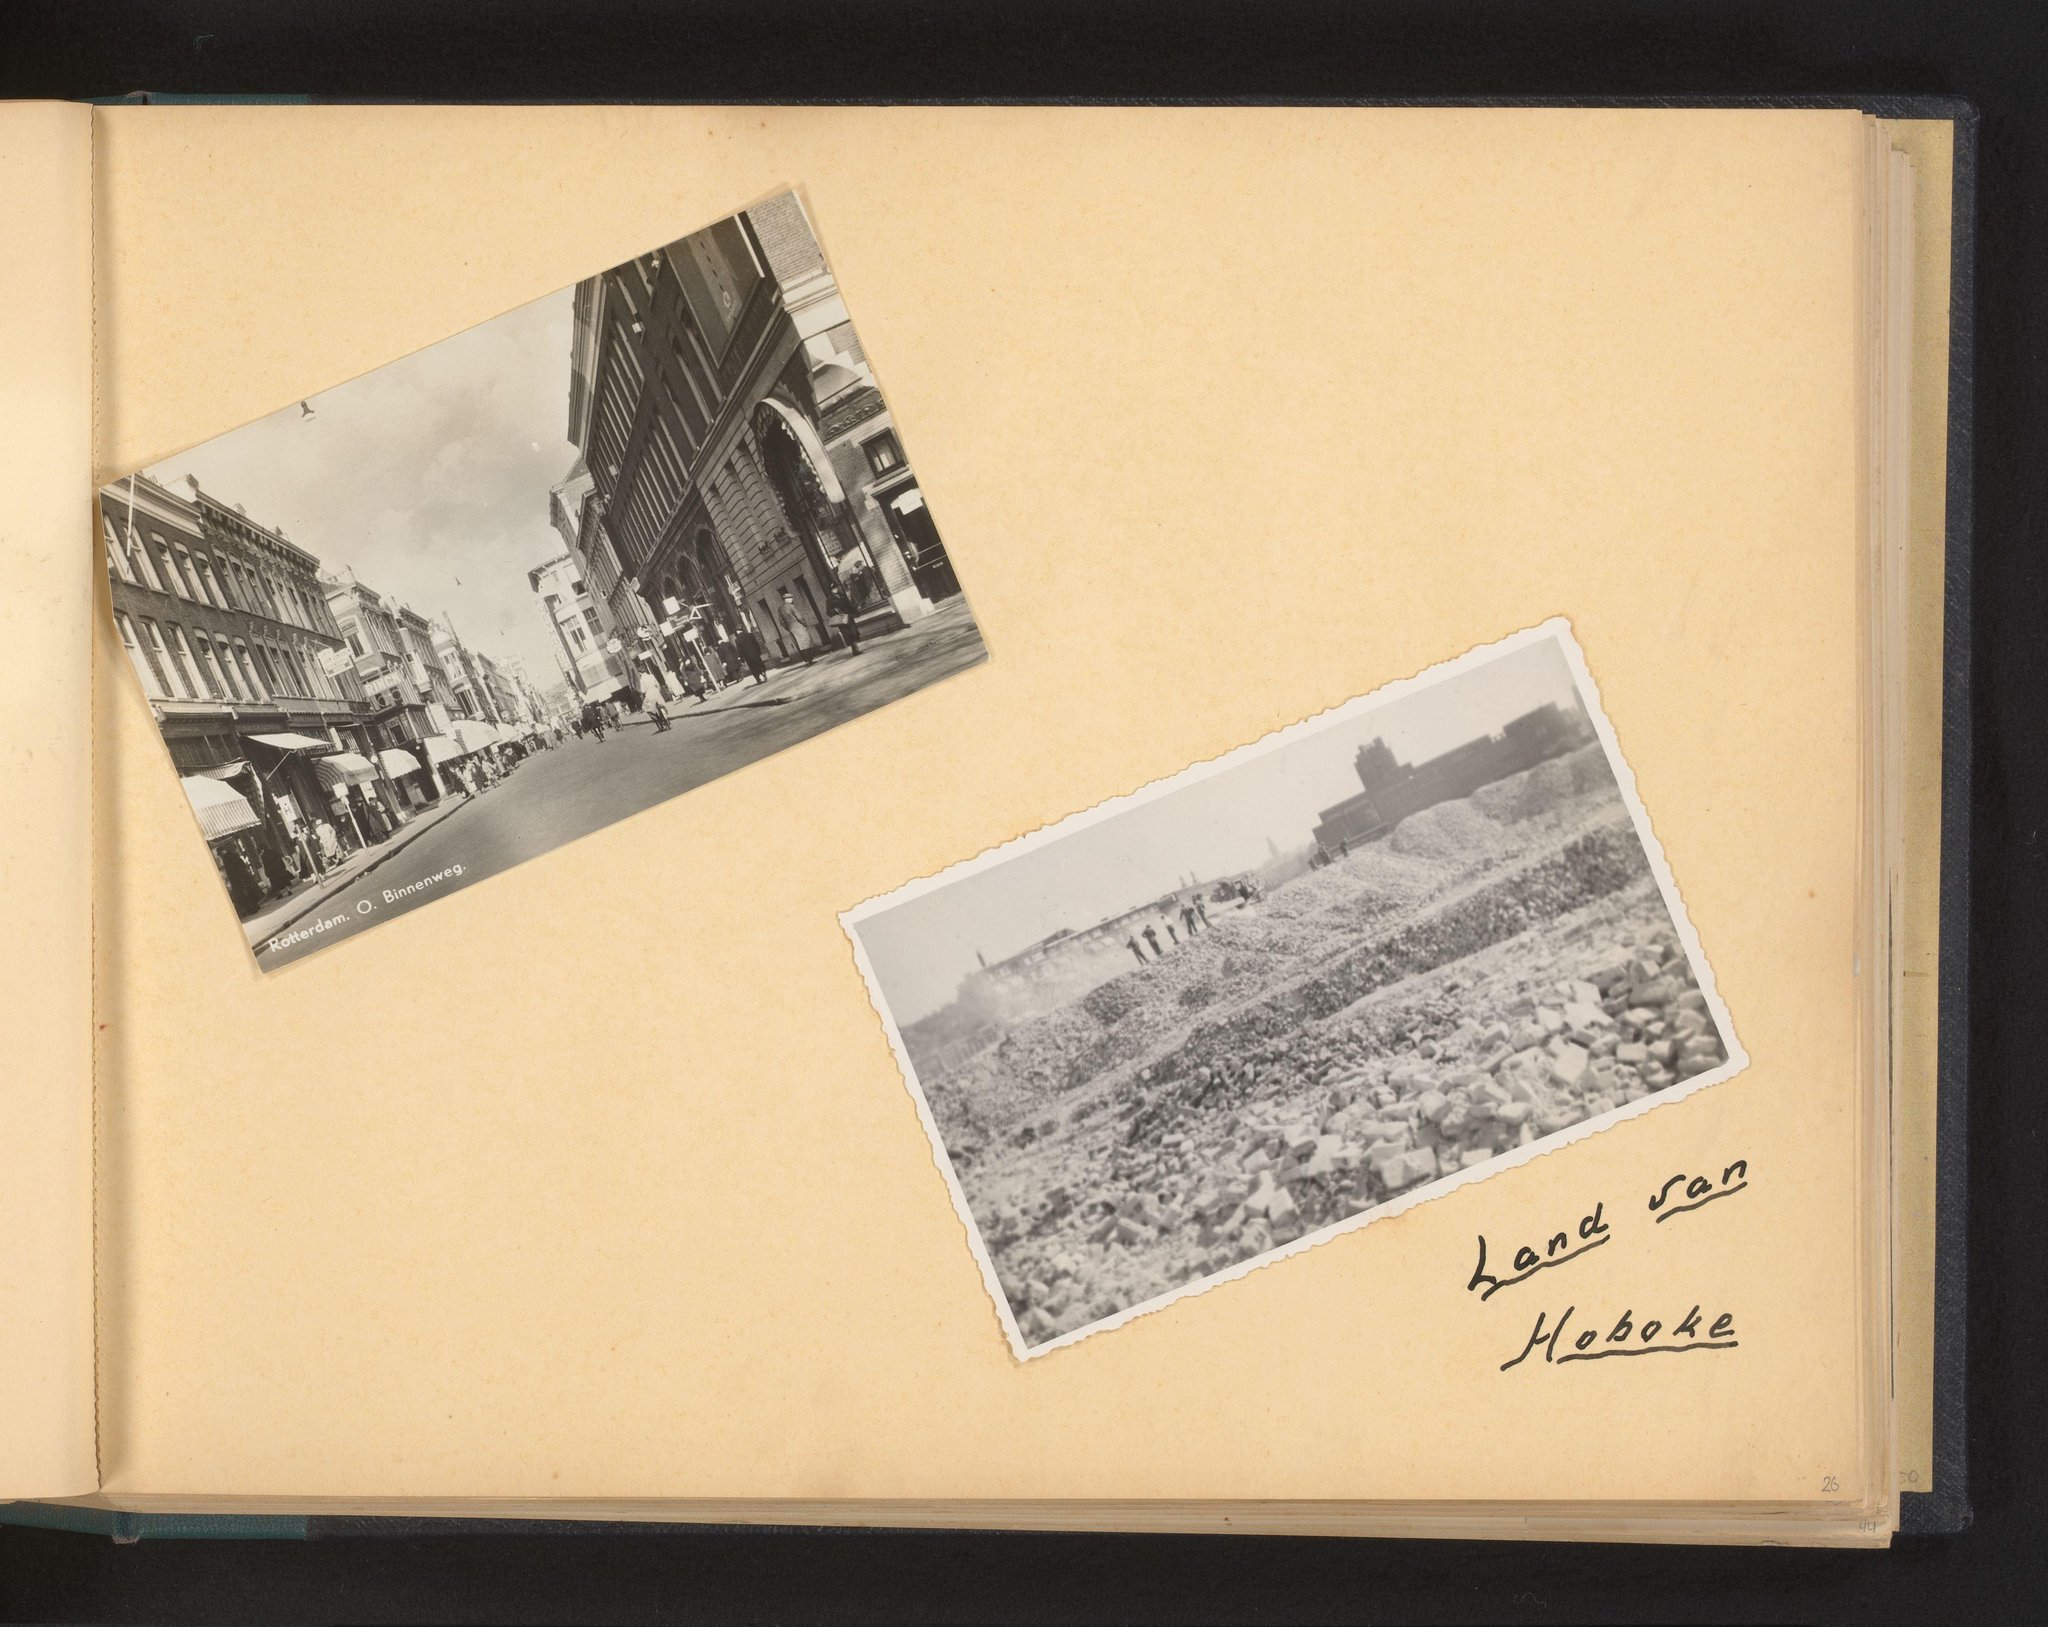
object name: ansichtkaart, prentbriefkaart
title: Land van Hoboke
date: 1940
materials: cardboard, photographic support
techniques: gelatin silver print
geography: rotterdam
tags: non-combatants ~ war, devastated, ruined place or city (~ warfare), rotterdam, rotterdam blitz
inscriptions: inscription: ‘Land van Hoboke’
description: Albumblad met twee prentbriefkaarten van de Oude Binnenweg en het Land van Hoboken te Rotterdam, voor en na het bombardement. Onderdeel van het fotoalbum over de verwoestingen van Nederlandse steden en infrastructuur in het begin van de Tweede Wereldoorlog.